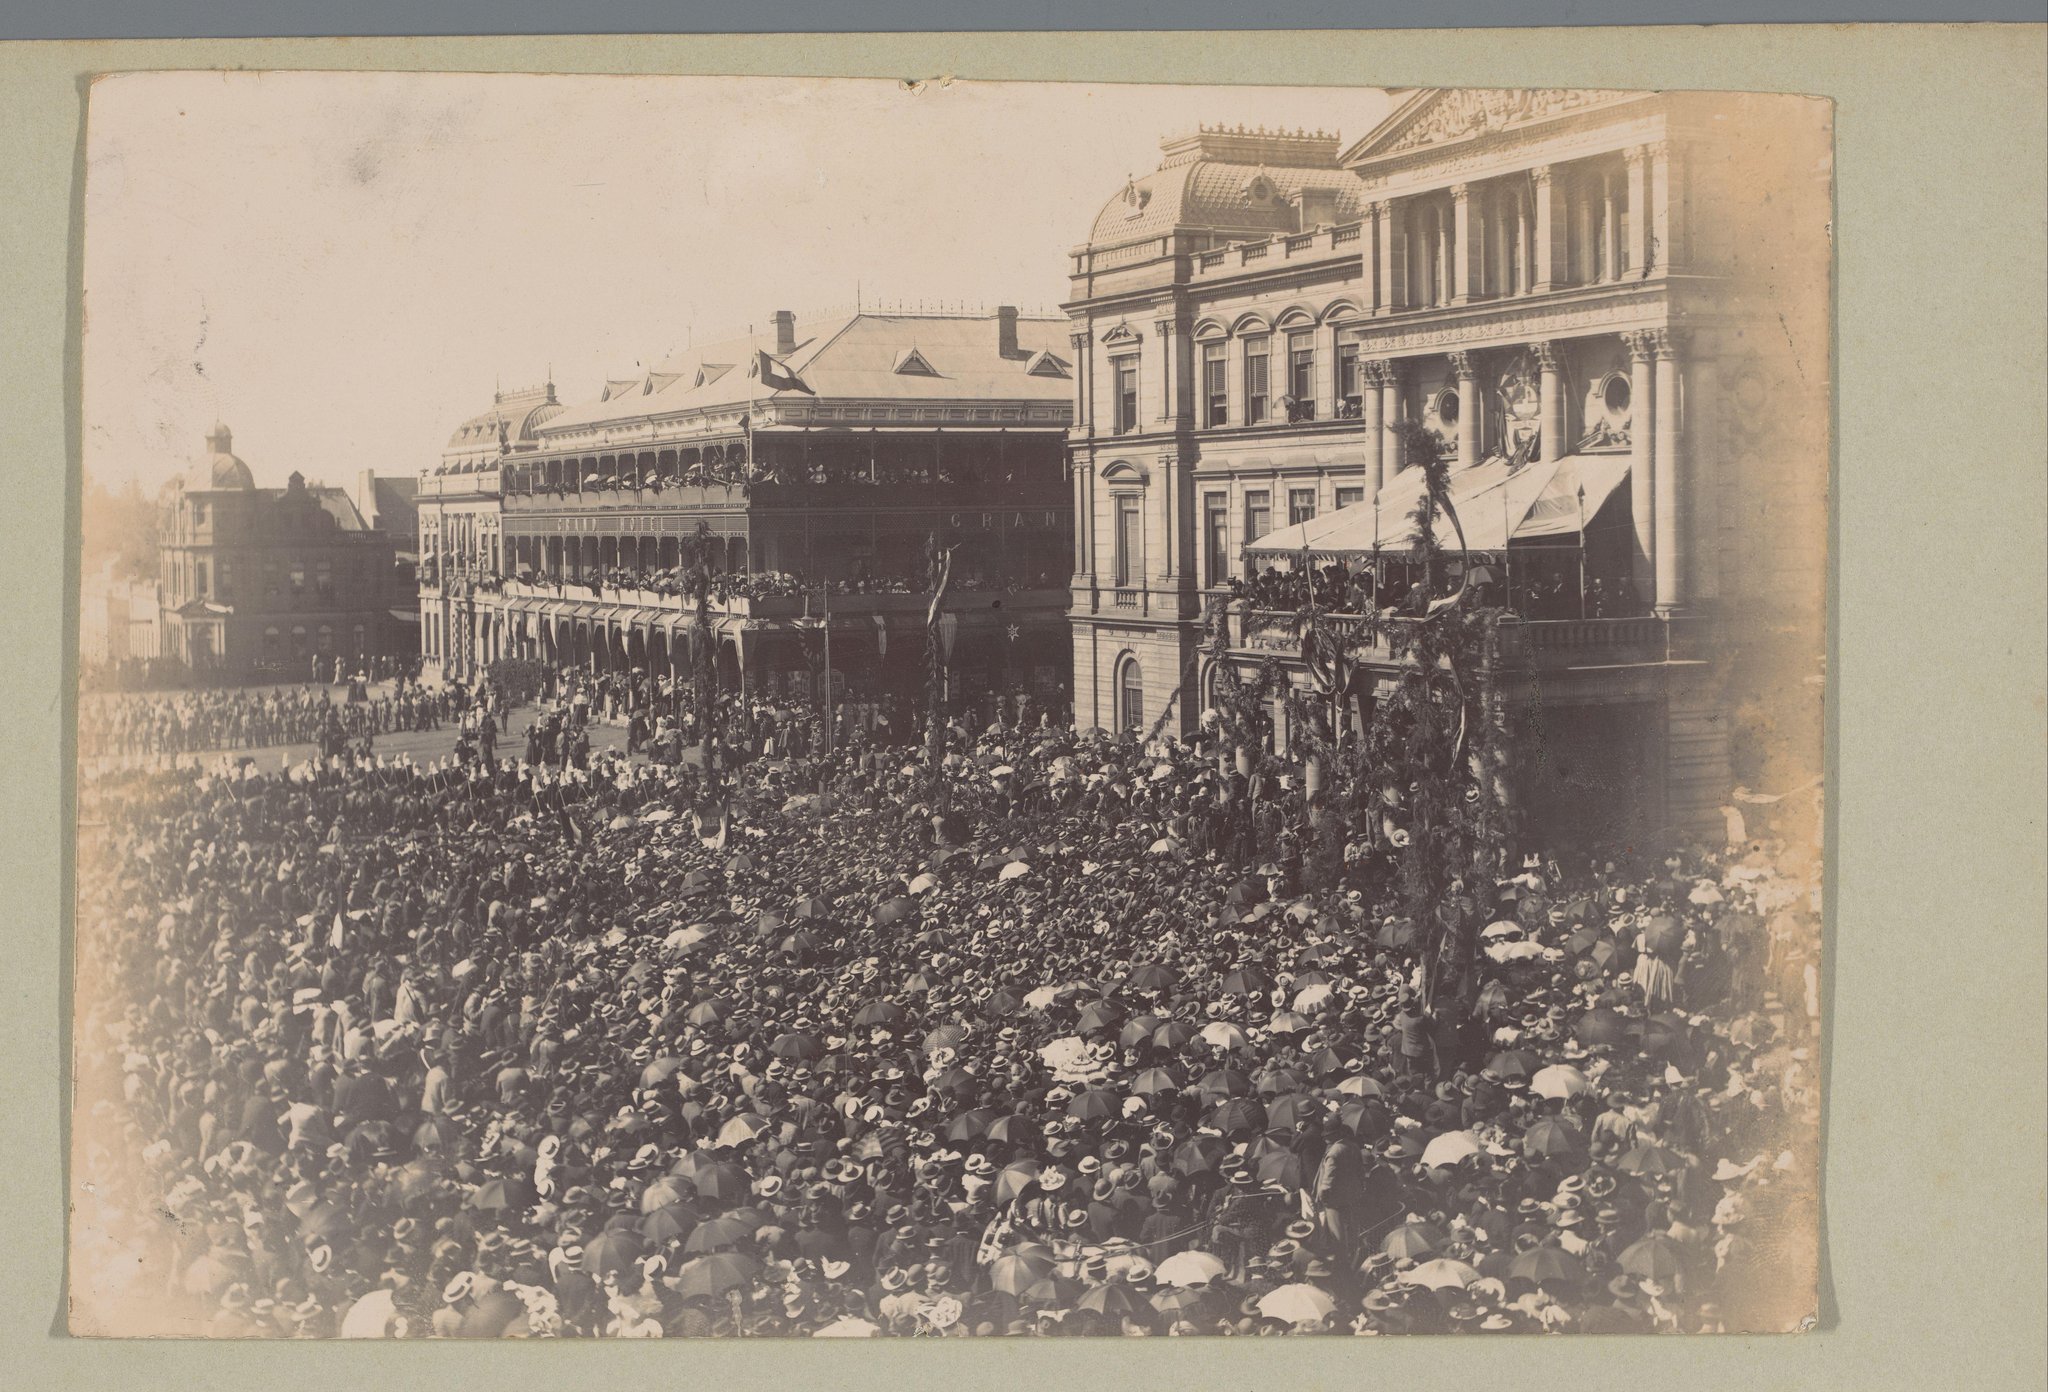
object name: photograph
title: Menigte op het Kerkplein in Pretoria tijdens de inhuldiging van president Kruger op 12 mei 1898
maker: Anonymous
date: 1898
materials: paper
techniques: gelatin silver print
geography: pretoria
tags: ceremonial celebration of installation of a ruler